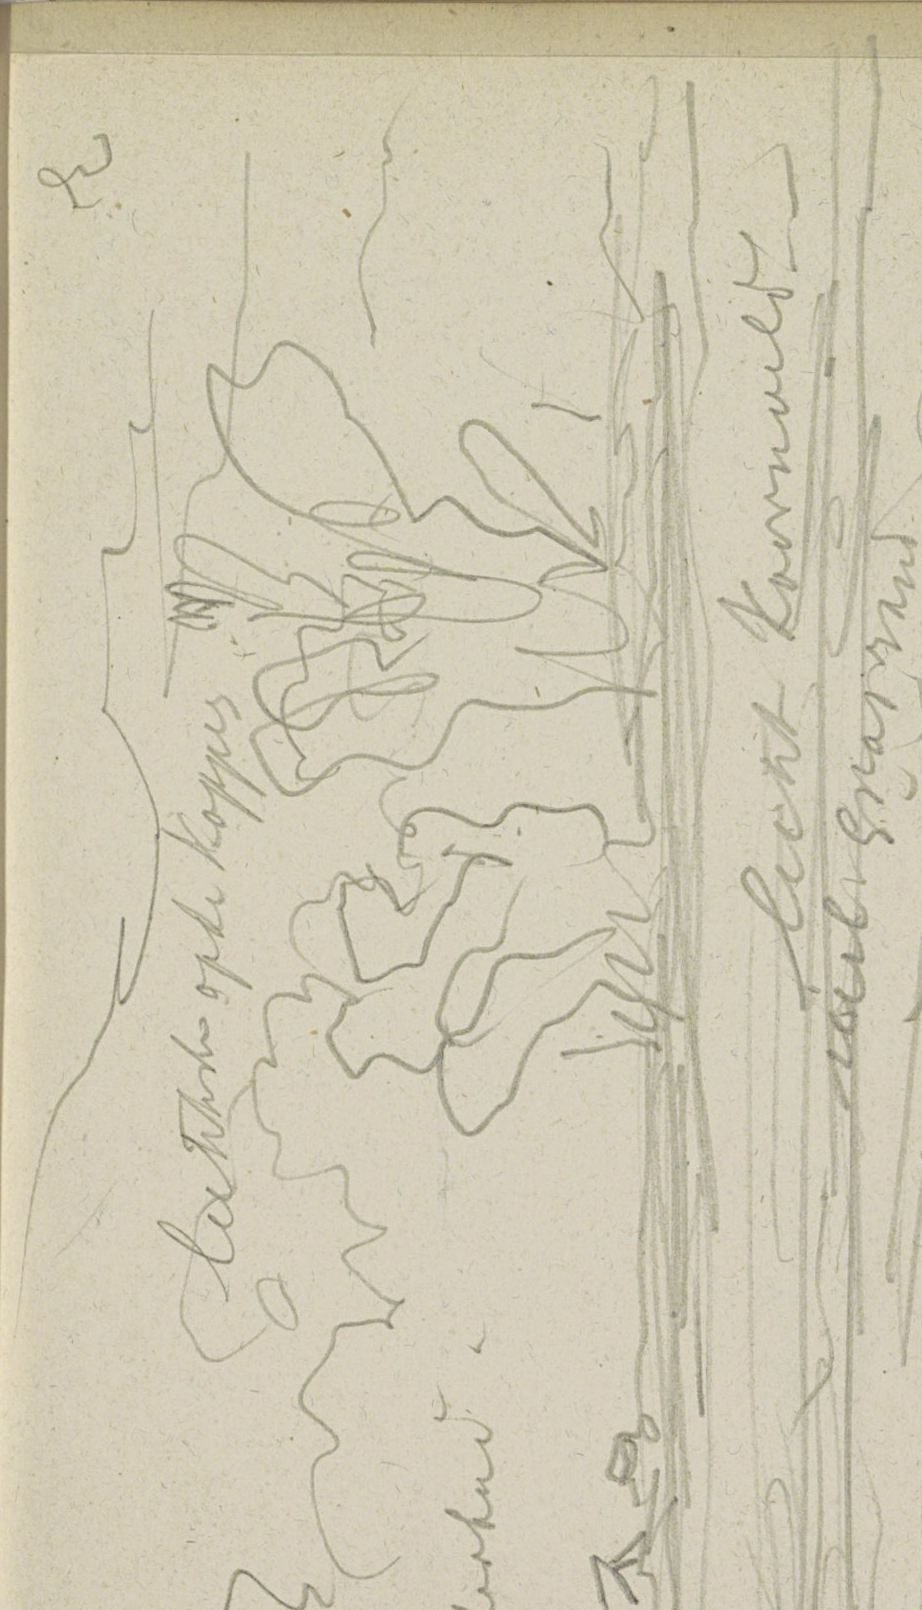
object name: sketchbook leaf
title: Korenveld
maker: johannes tavenraat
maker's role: draughtsman, painter, print maker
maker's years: 1809-1881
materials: paper, pencil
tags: landscapes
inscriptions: kleurnotitie, handgeschreven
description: Blad 41 recto uit een schetsboek met 88 bladen.